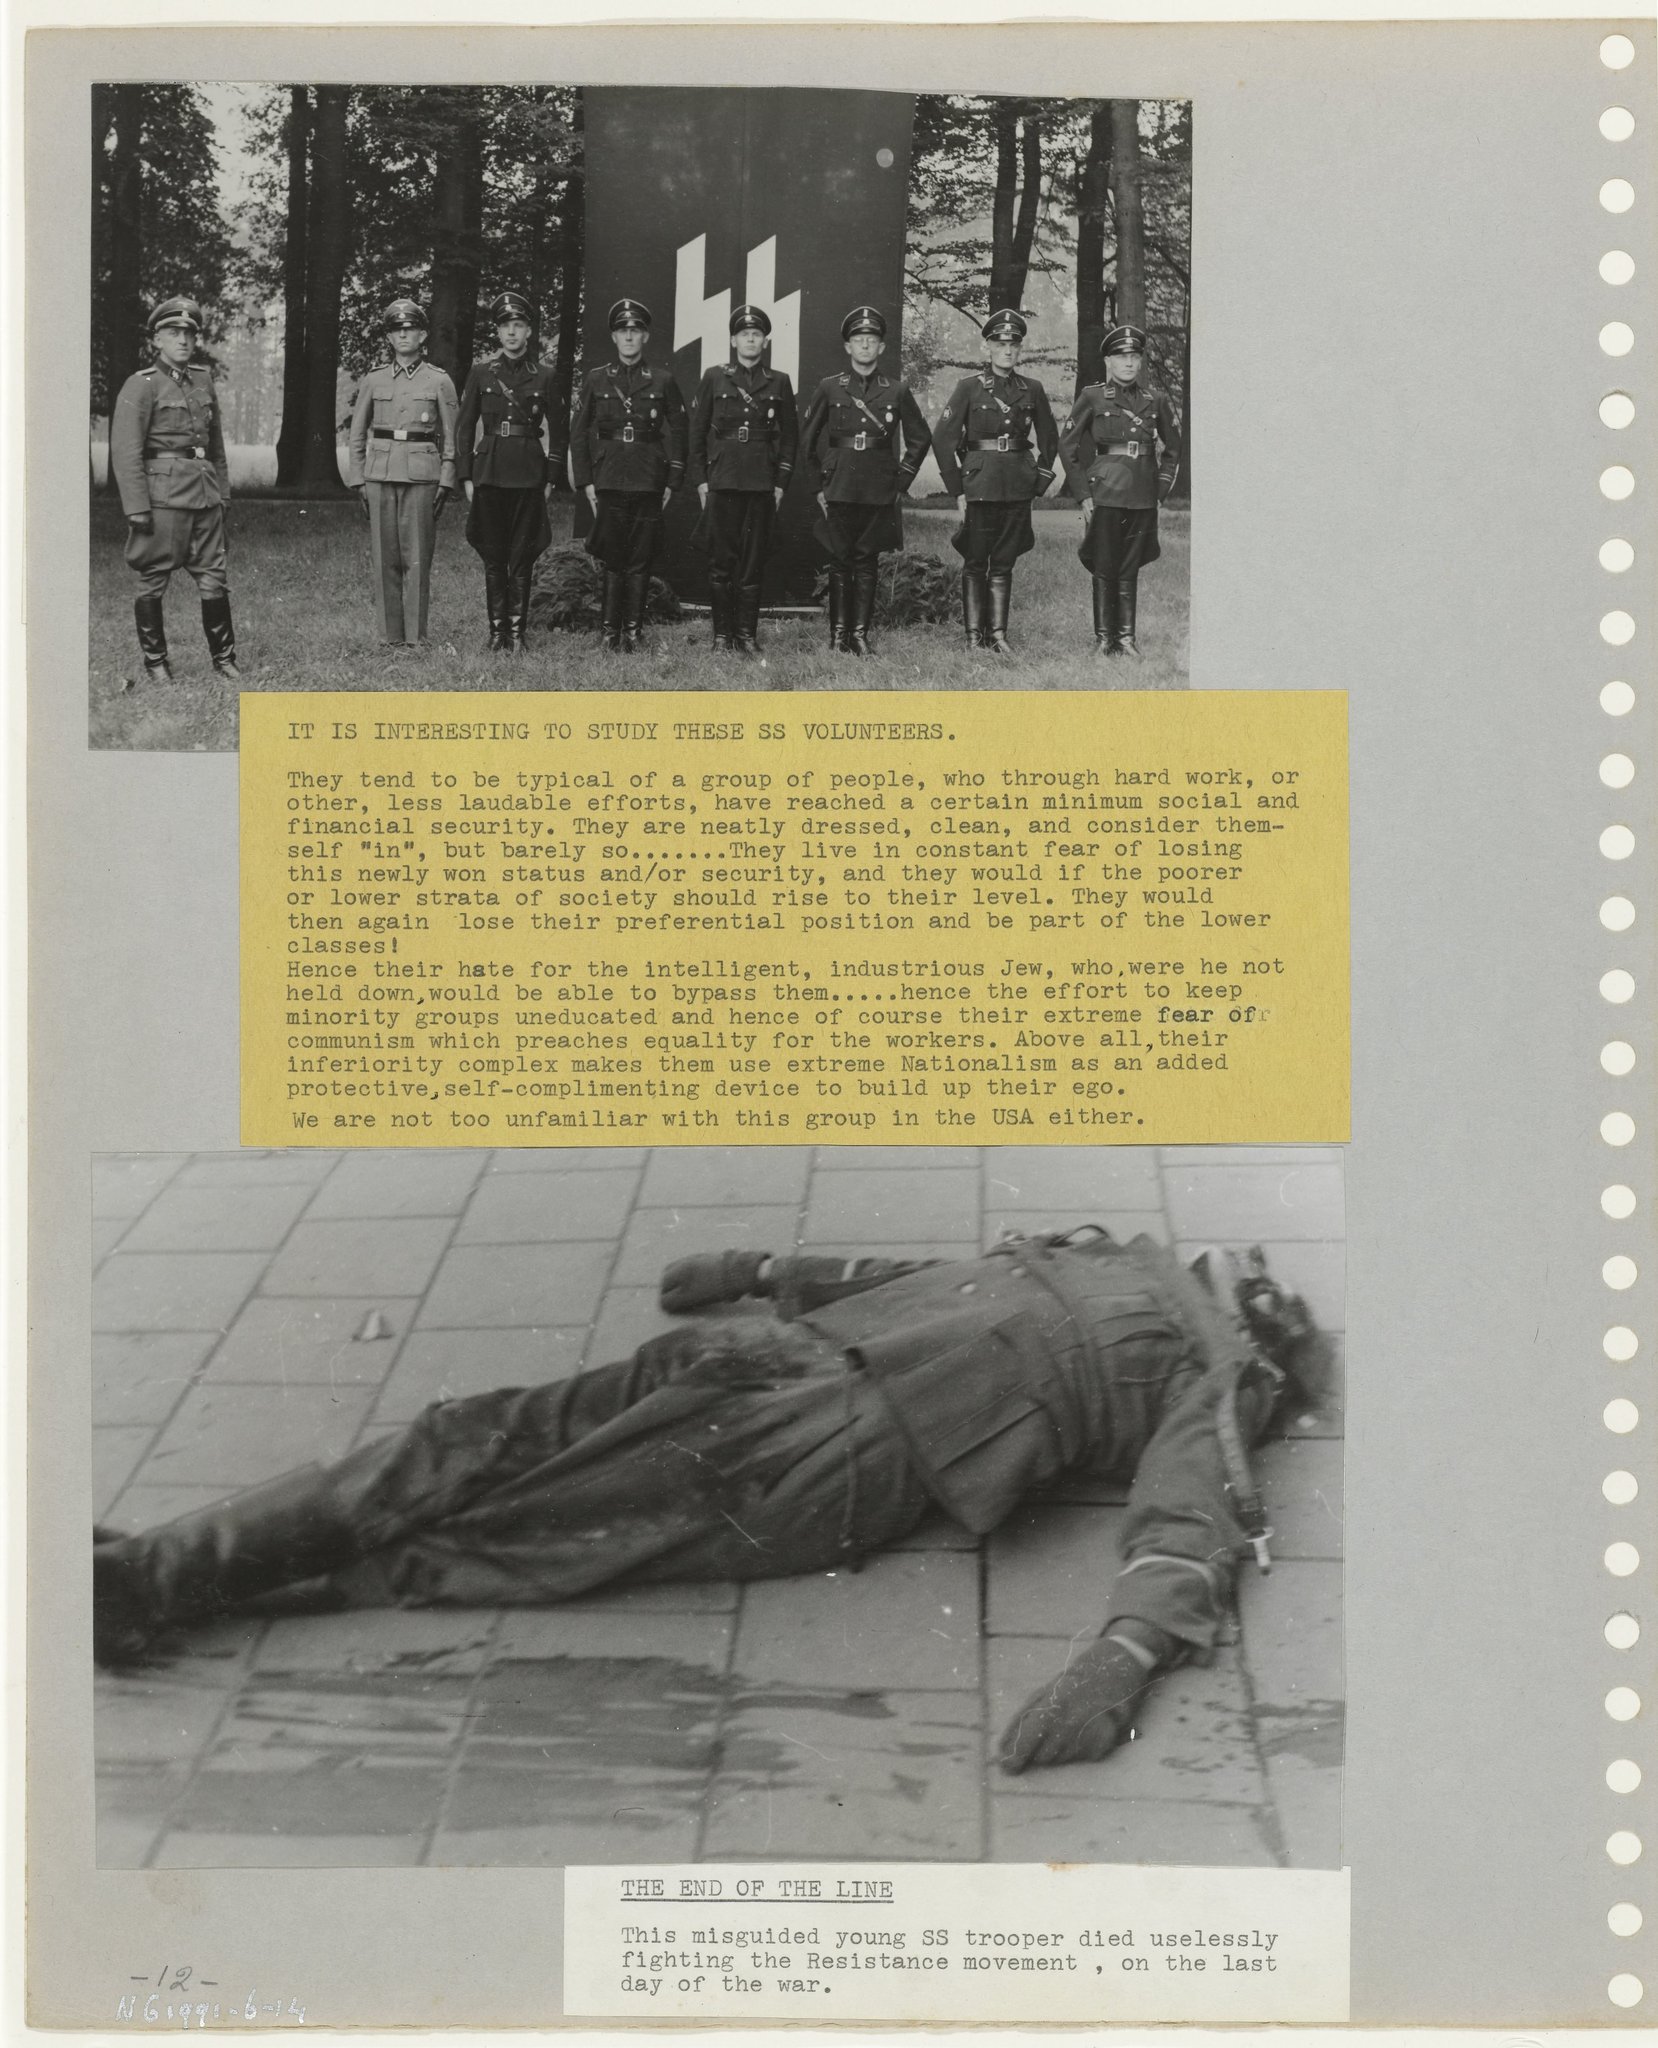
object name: photograph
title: Nederlandse SS-ers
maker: Anonymous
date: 1905-1945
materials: paper, plastic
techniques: photography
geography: netherlands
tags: amsterdam, tonny van renterghem, berlin, fritz kahlenberg, volunteers ~ enlisting, underground movement, partisans, netherlands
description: Twee foto's van de Nederlandse SS: Nederlandse SS-ers tijdens de eedaflegging ( boven). Dode Nederlandse SS-er, geliquideerd door het verzet op de laatste dag van de oorlog (onder).